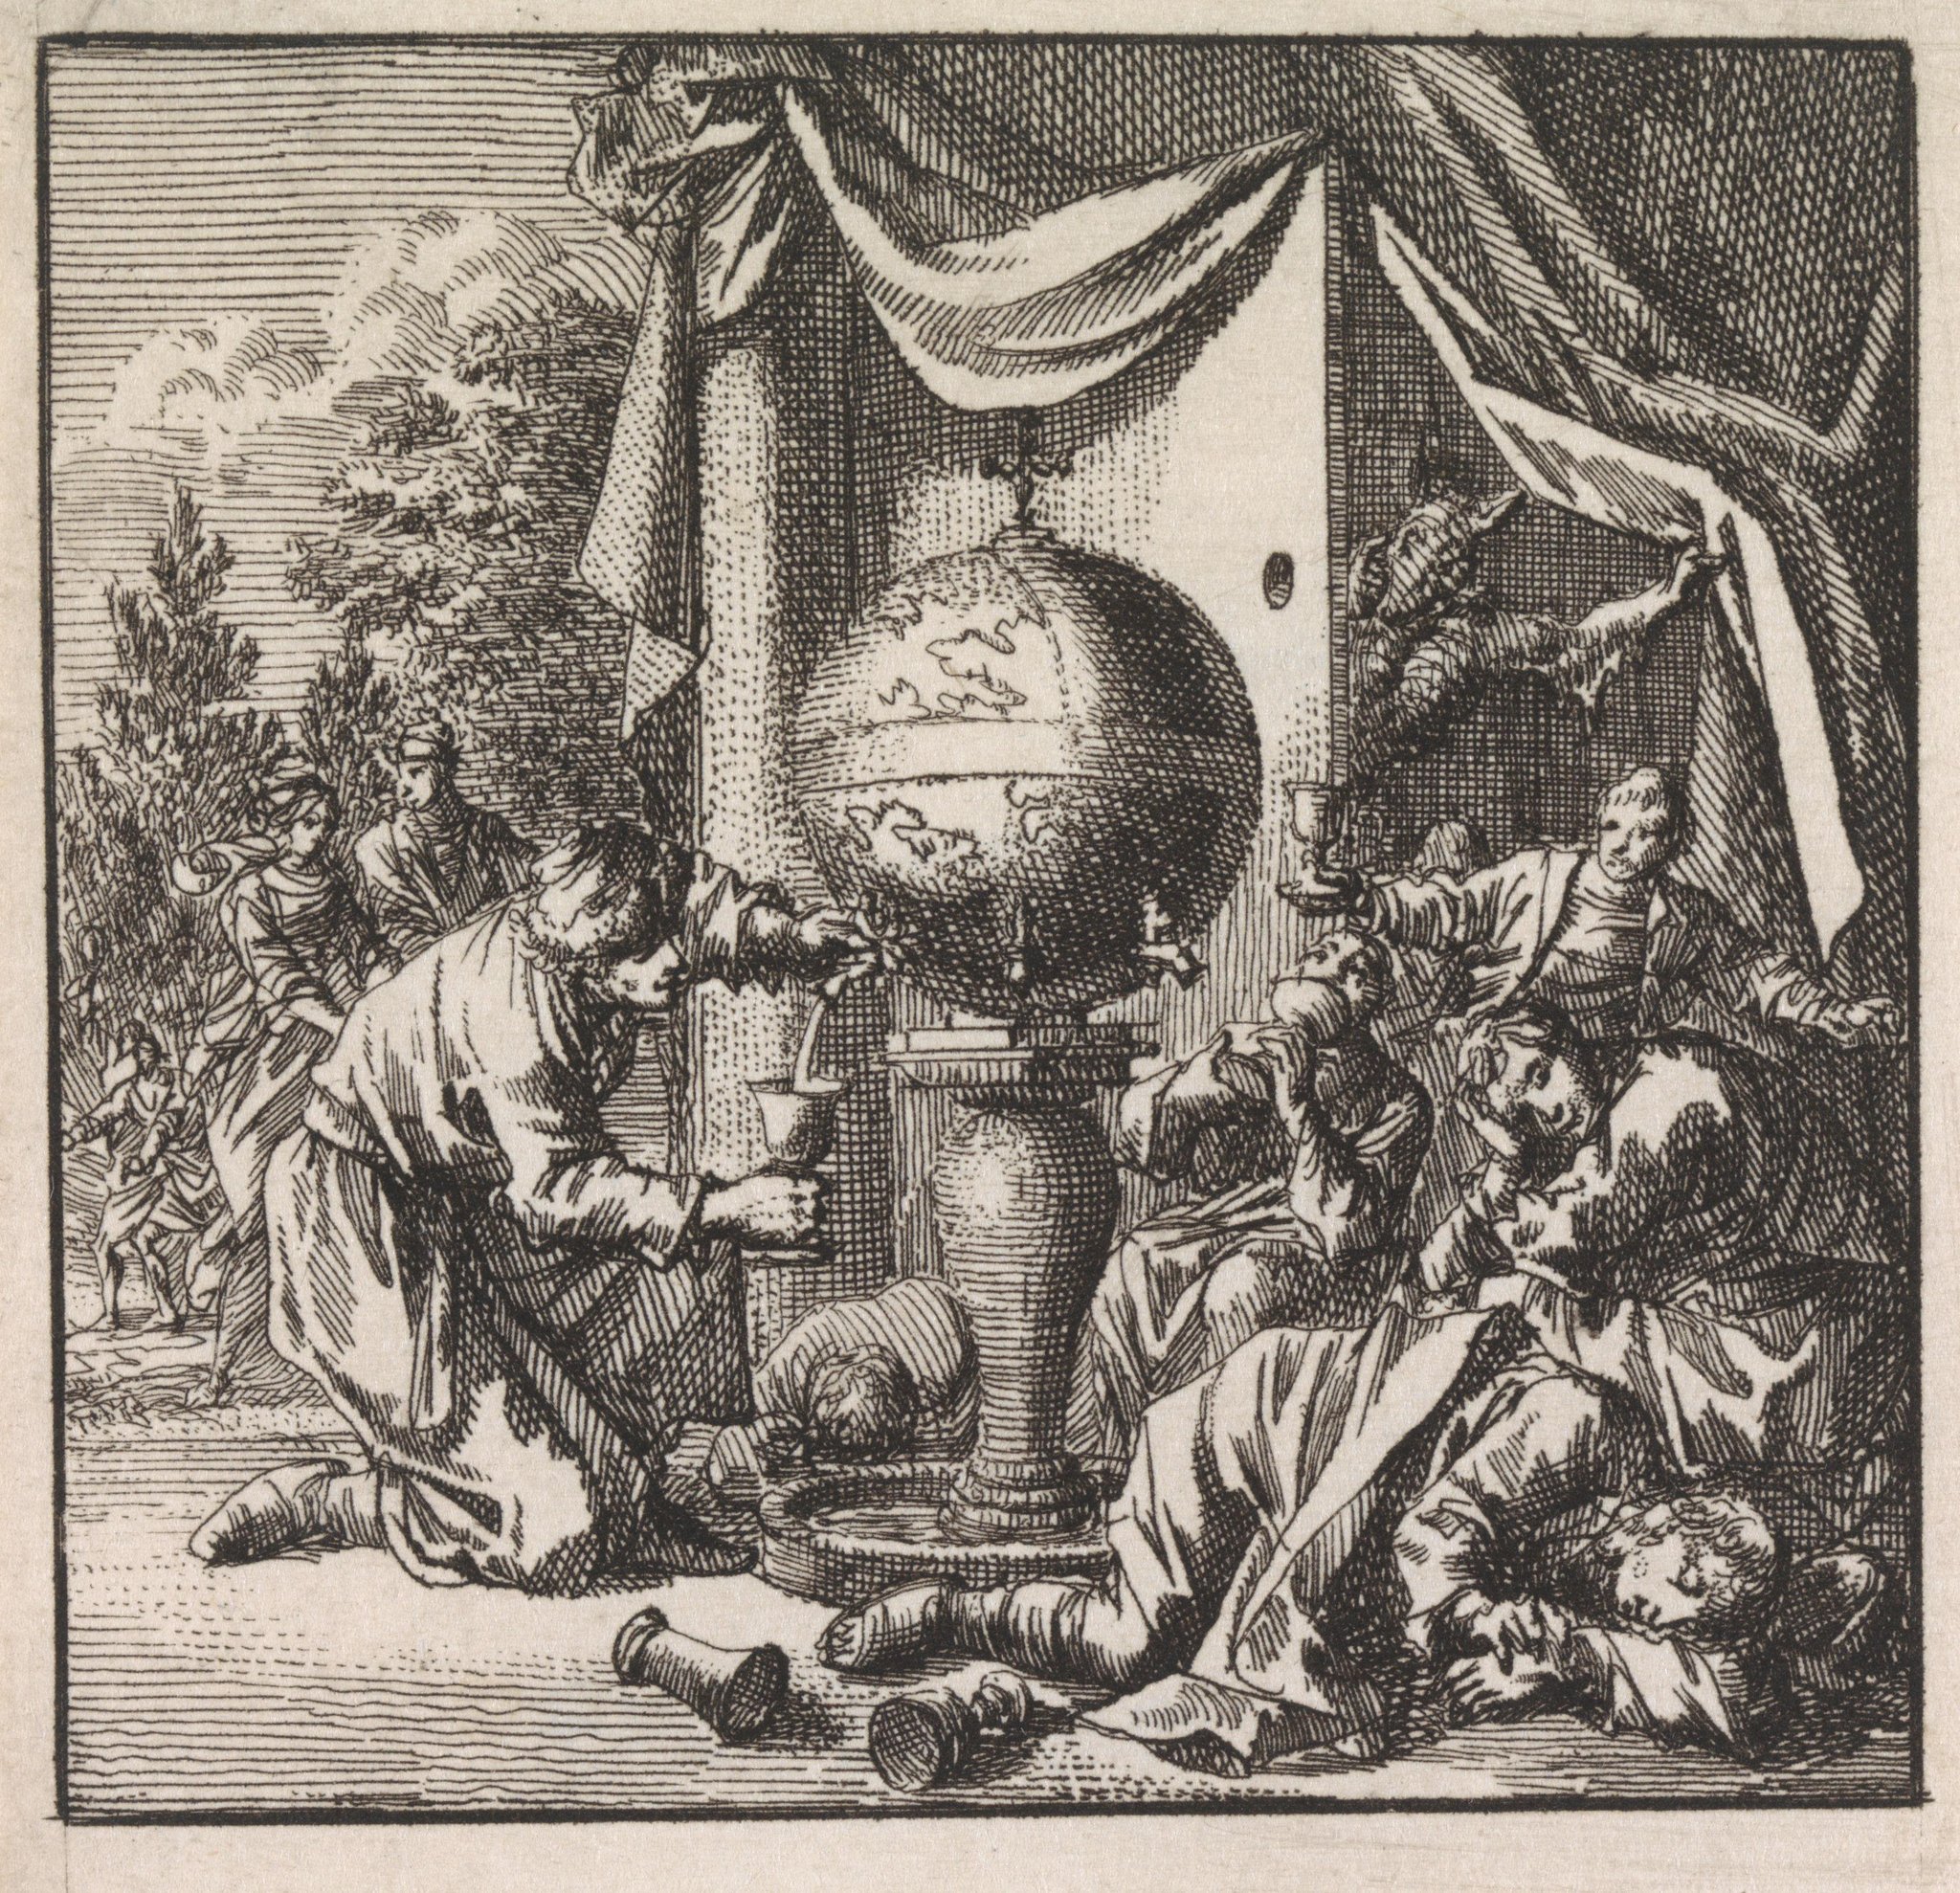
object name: print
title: Dronken figuren rond een tap die de vorm van de wereldbol heeft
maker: jan luyken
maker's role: draughtsman, print maker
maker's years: 1649-1712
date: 1710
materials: paper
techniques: etching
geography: amsterdam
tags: earth, world as celestial body, alcoholic drinks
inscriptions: collector's mark: Lugt 2228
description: Proefdruk voor illustratie uit: Luyken, Jan. De onwaardige wereld, vertoond in vyftig zinnebeelden, met godlyke spreuken en stichtelyke verzen. Amsterdam: Pieter Arentsz. II (wed.) en Cornelis van der Sys, 1710, p. 124.